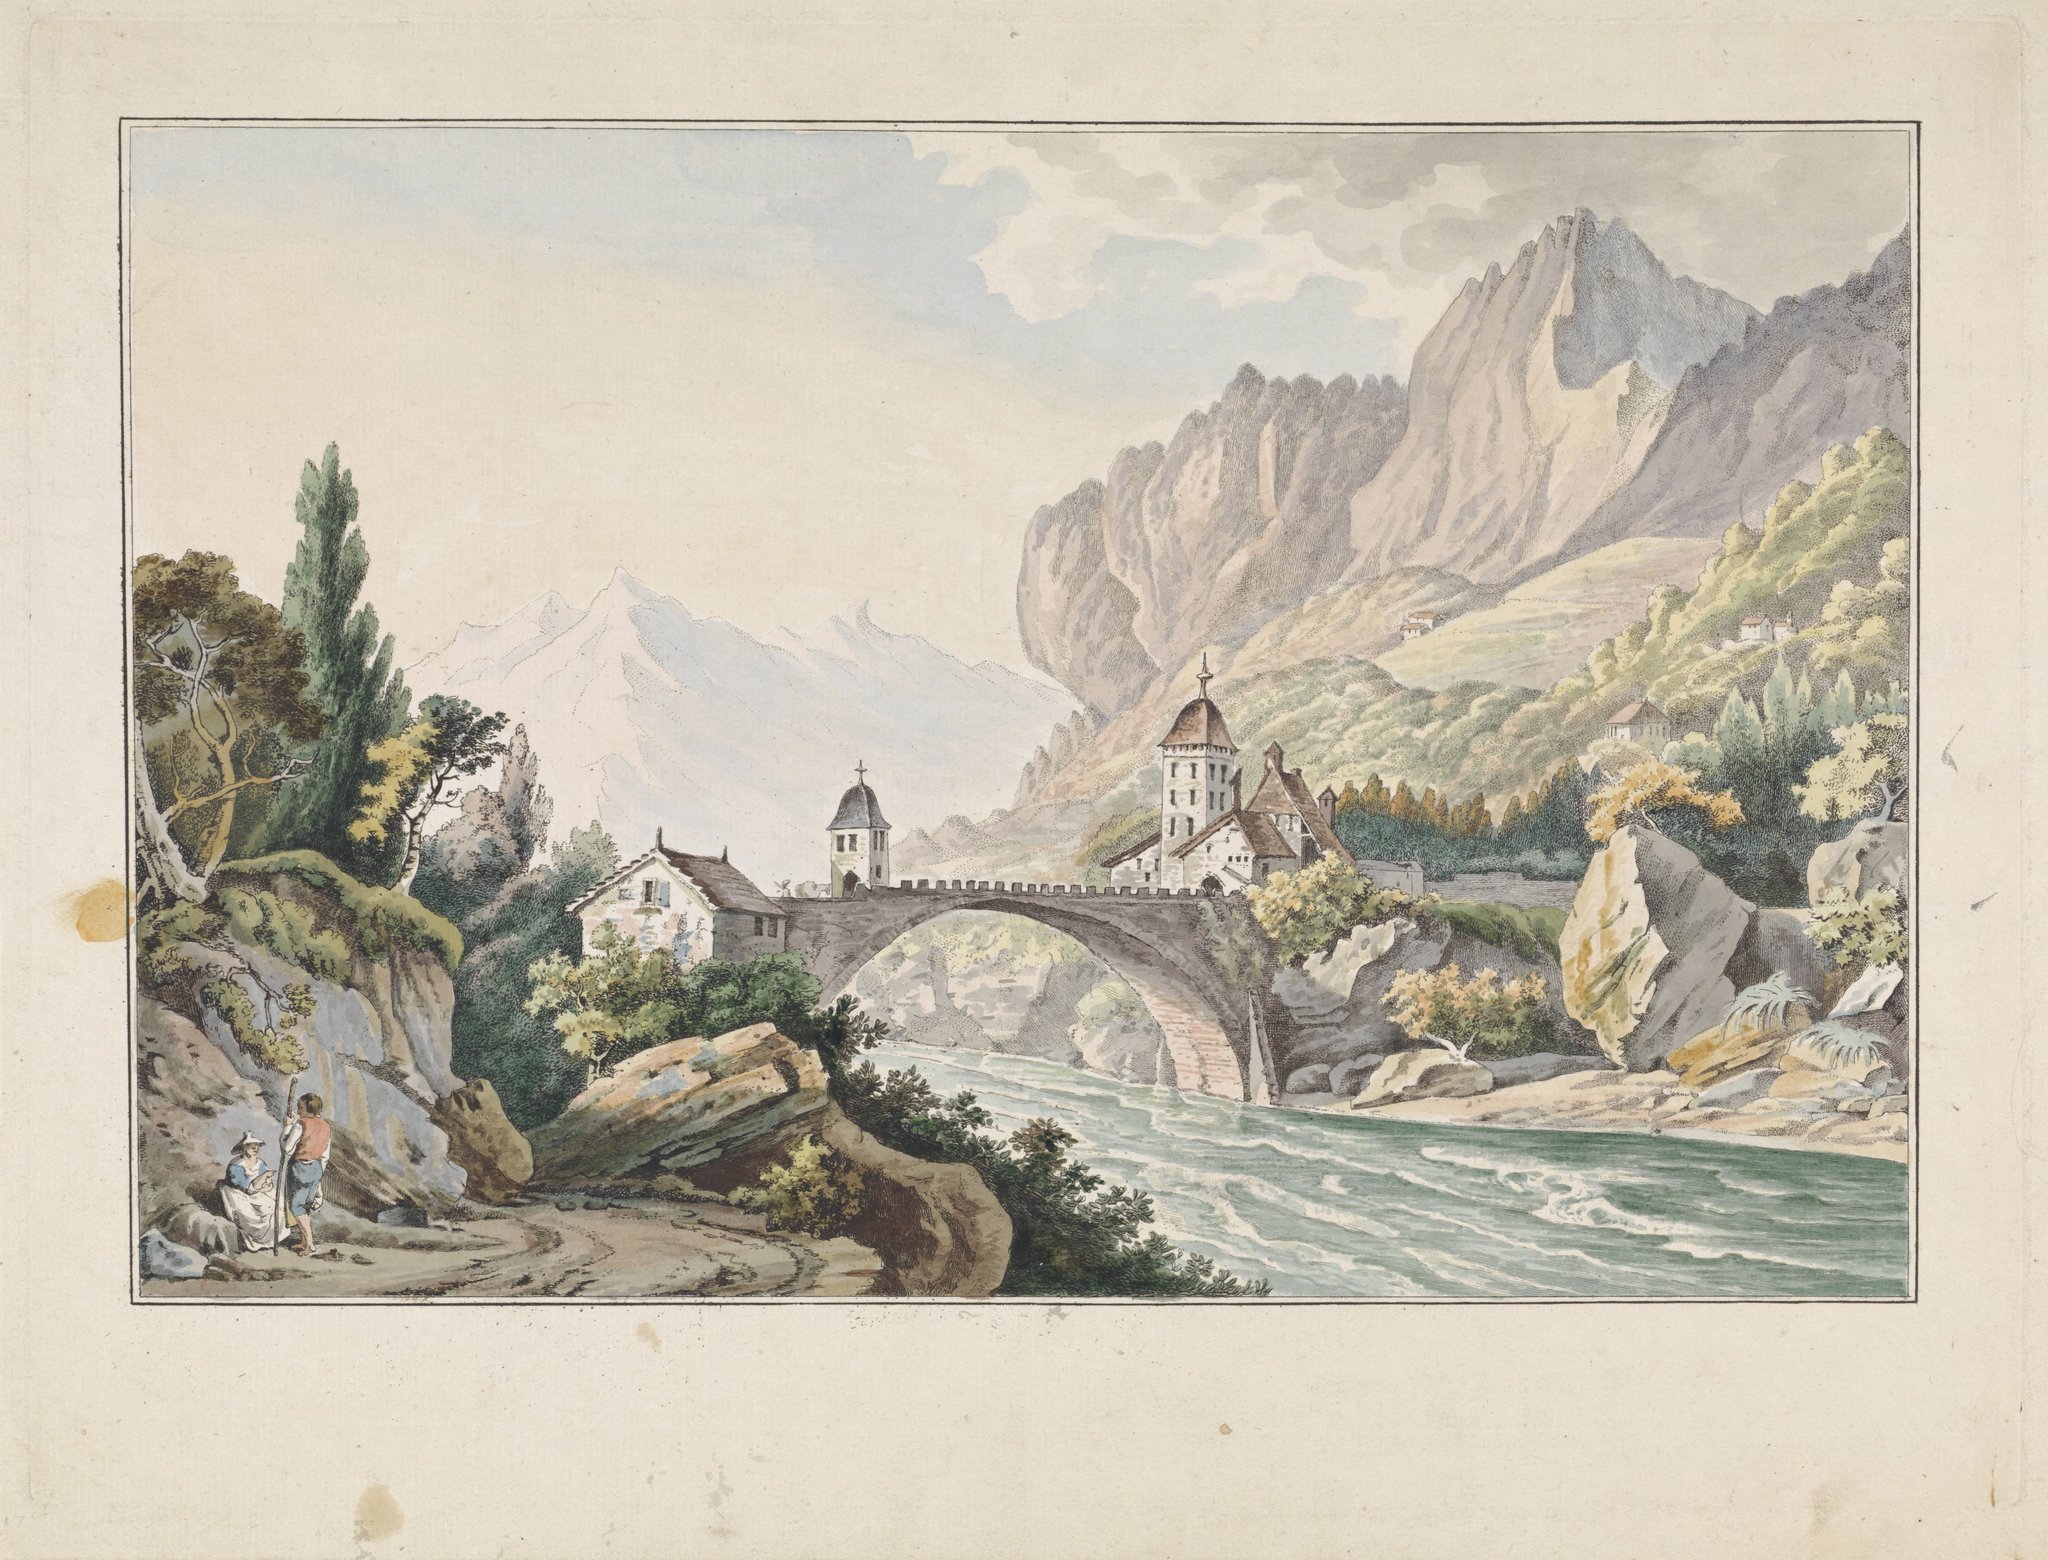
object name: print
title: Gezicht op de brug bij Saint Maurice te Zwitserland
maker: jan gerard waldorp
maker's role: draughtsman, print maker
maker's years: 1740-1808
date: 1792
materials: paper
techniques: etching, hand coloring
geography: amsterdam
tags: saint-maurice (zwitserland)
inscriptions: collector's mark: Lugt 2228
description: Bergachtig landschap met de brug bij Saint Maurice te Zwitserland. Op een pad zijn een man en vrouw in gesprek.